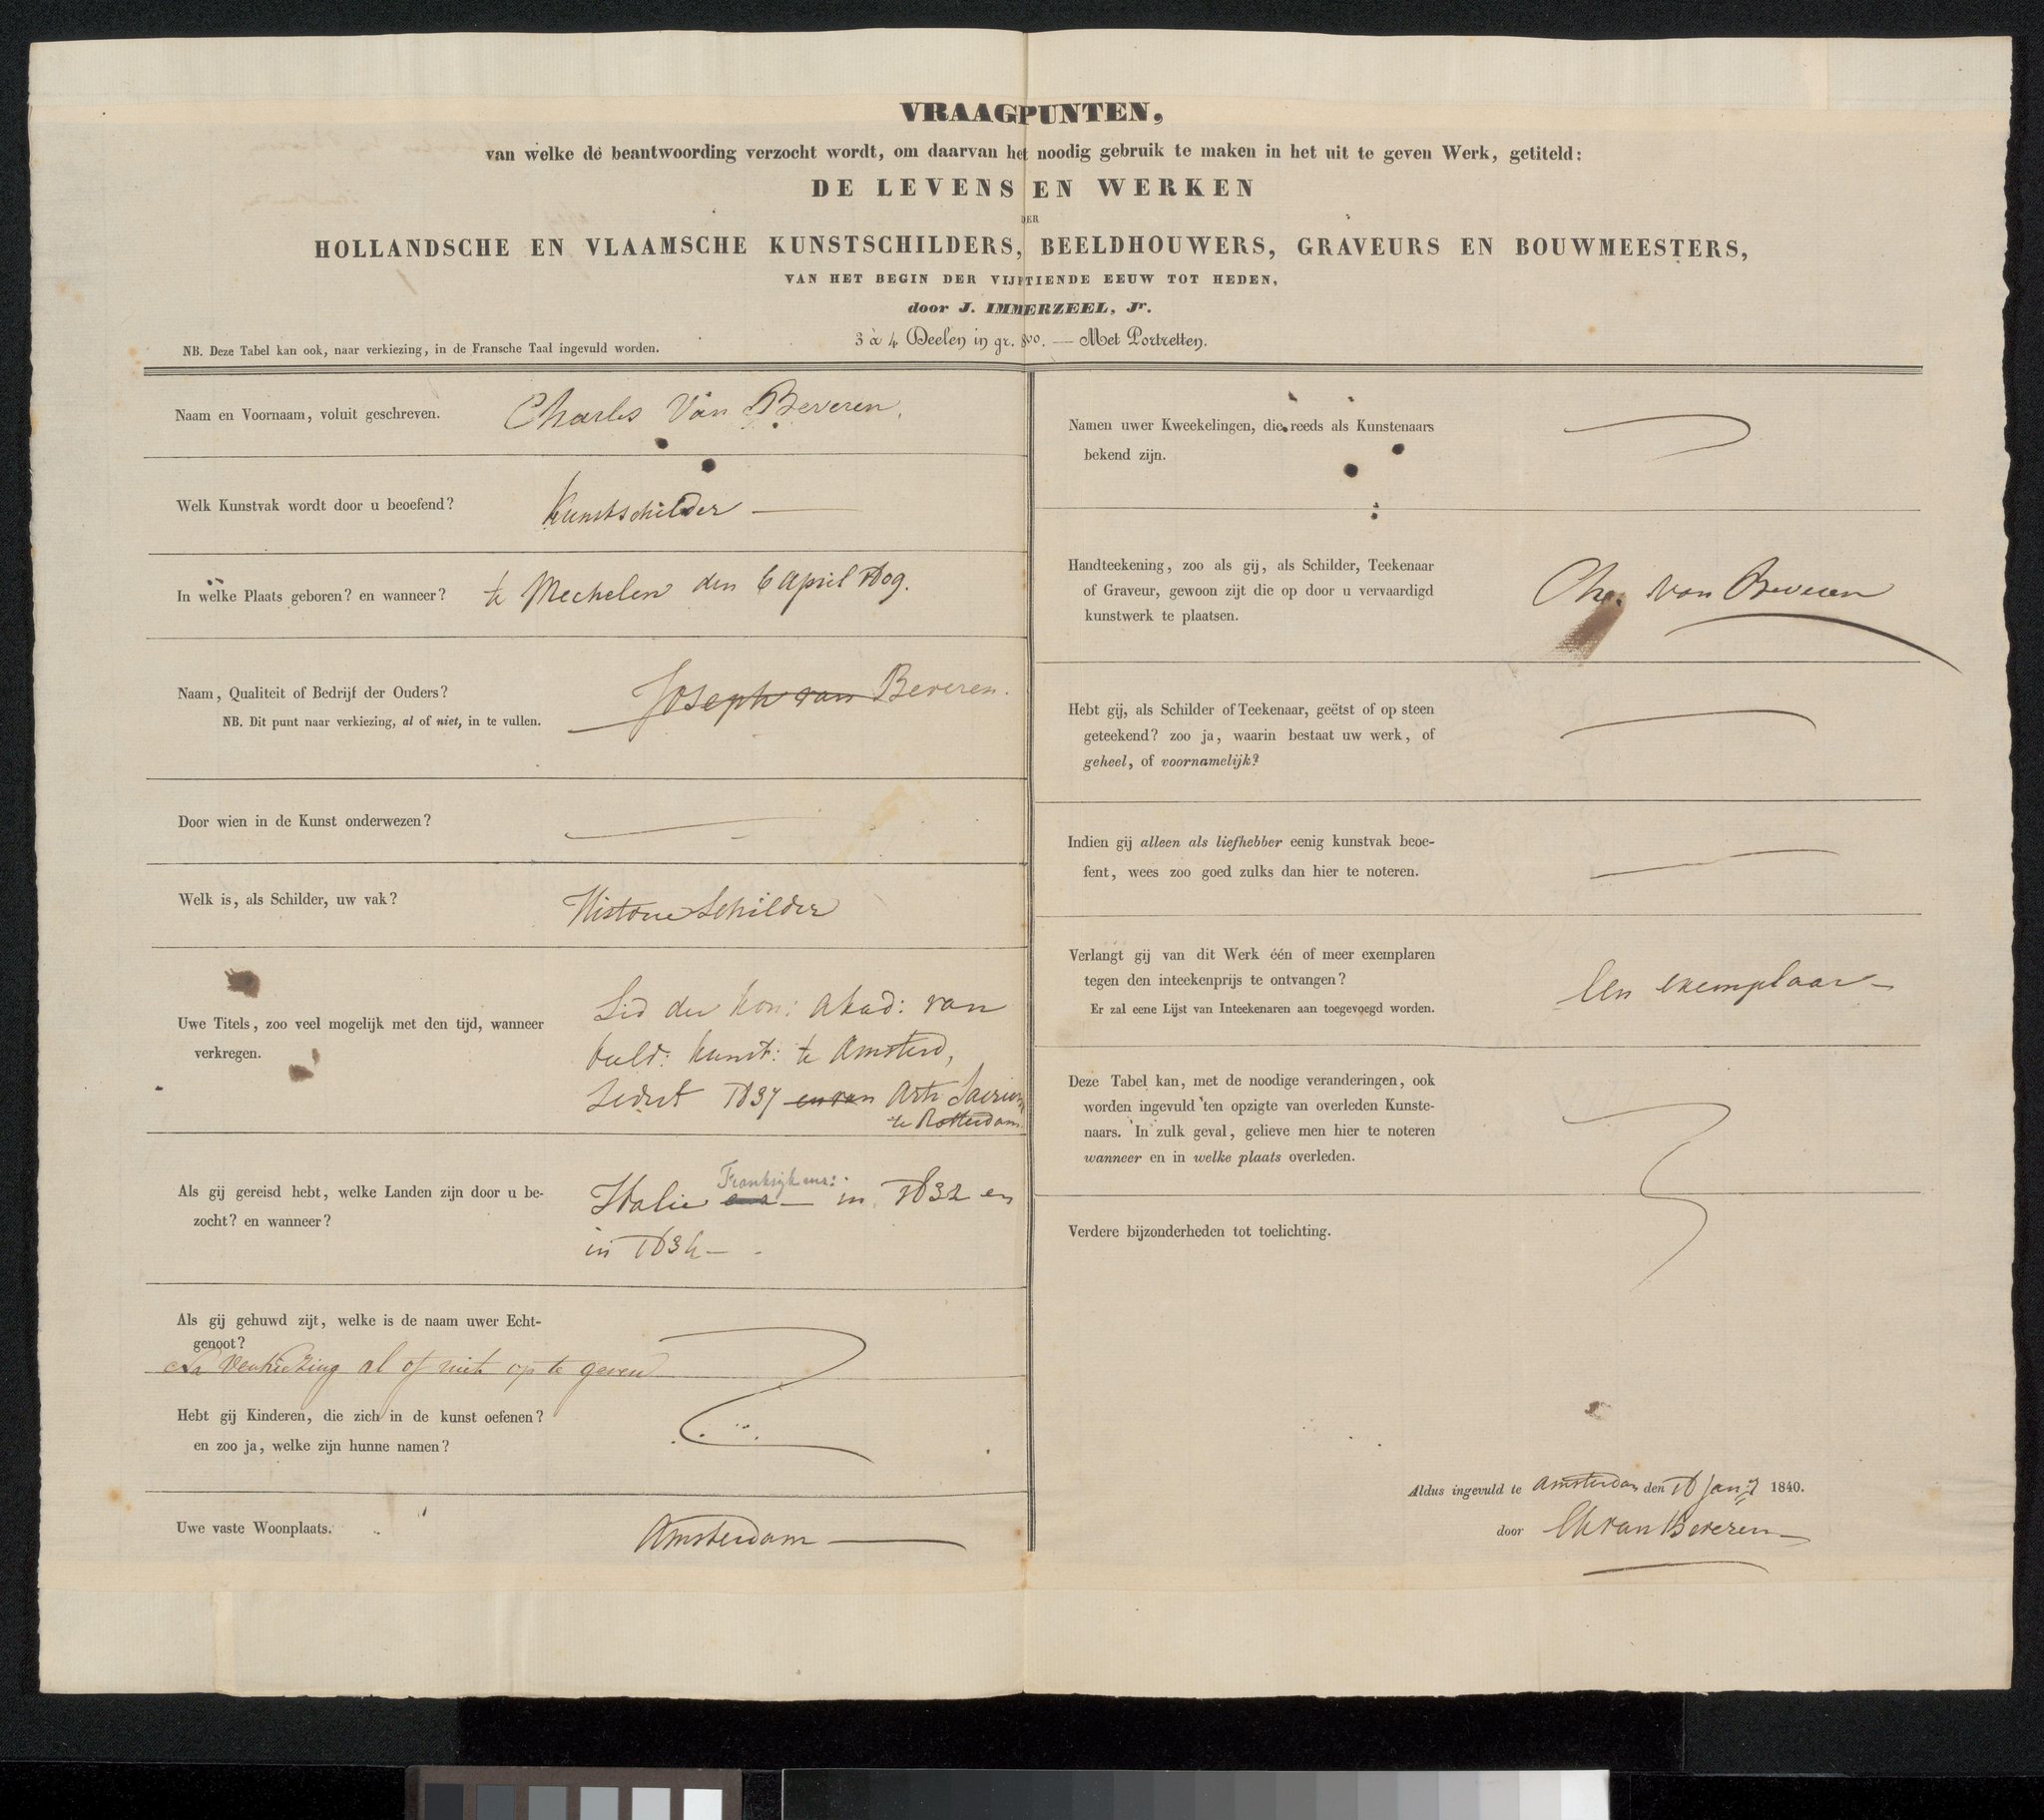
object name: questionnaire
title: Enquêteformulier ingevuld door Charles van Beveren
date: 1840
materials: ink, paper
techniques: pen, printing, writing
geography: amsterdam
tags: mechelen, amsterdam, painter, charles van beveren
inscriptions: watermark, inscription: ‘Vraagpunten,/ van welke de beantwoording verzocht wordt, om daarvan het noodig gebruik te maken in het uit te geven Werk, getiteld: De levens en werken/ der Hollandsche en Vlaamsche kunstschilders, beeldhouwers,/ graveurs en bouwmeesters, van het begin der vijftiende eeuw tot heden/ door J. Immerzeel, Jr.’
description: Opgenomen in: Immerzeel, J. Jr., De levens en werken der Hollandsche en Vlaamsche kunstschilders, beeldhouwers, graveurs en bouwmeesters, van het begin der vijftiende eeuw tot heden, Amsterdam: J.C. van Kesteren, 1842-1843.